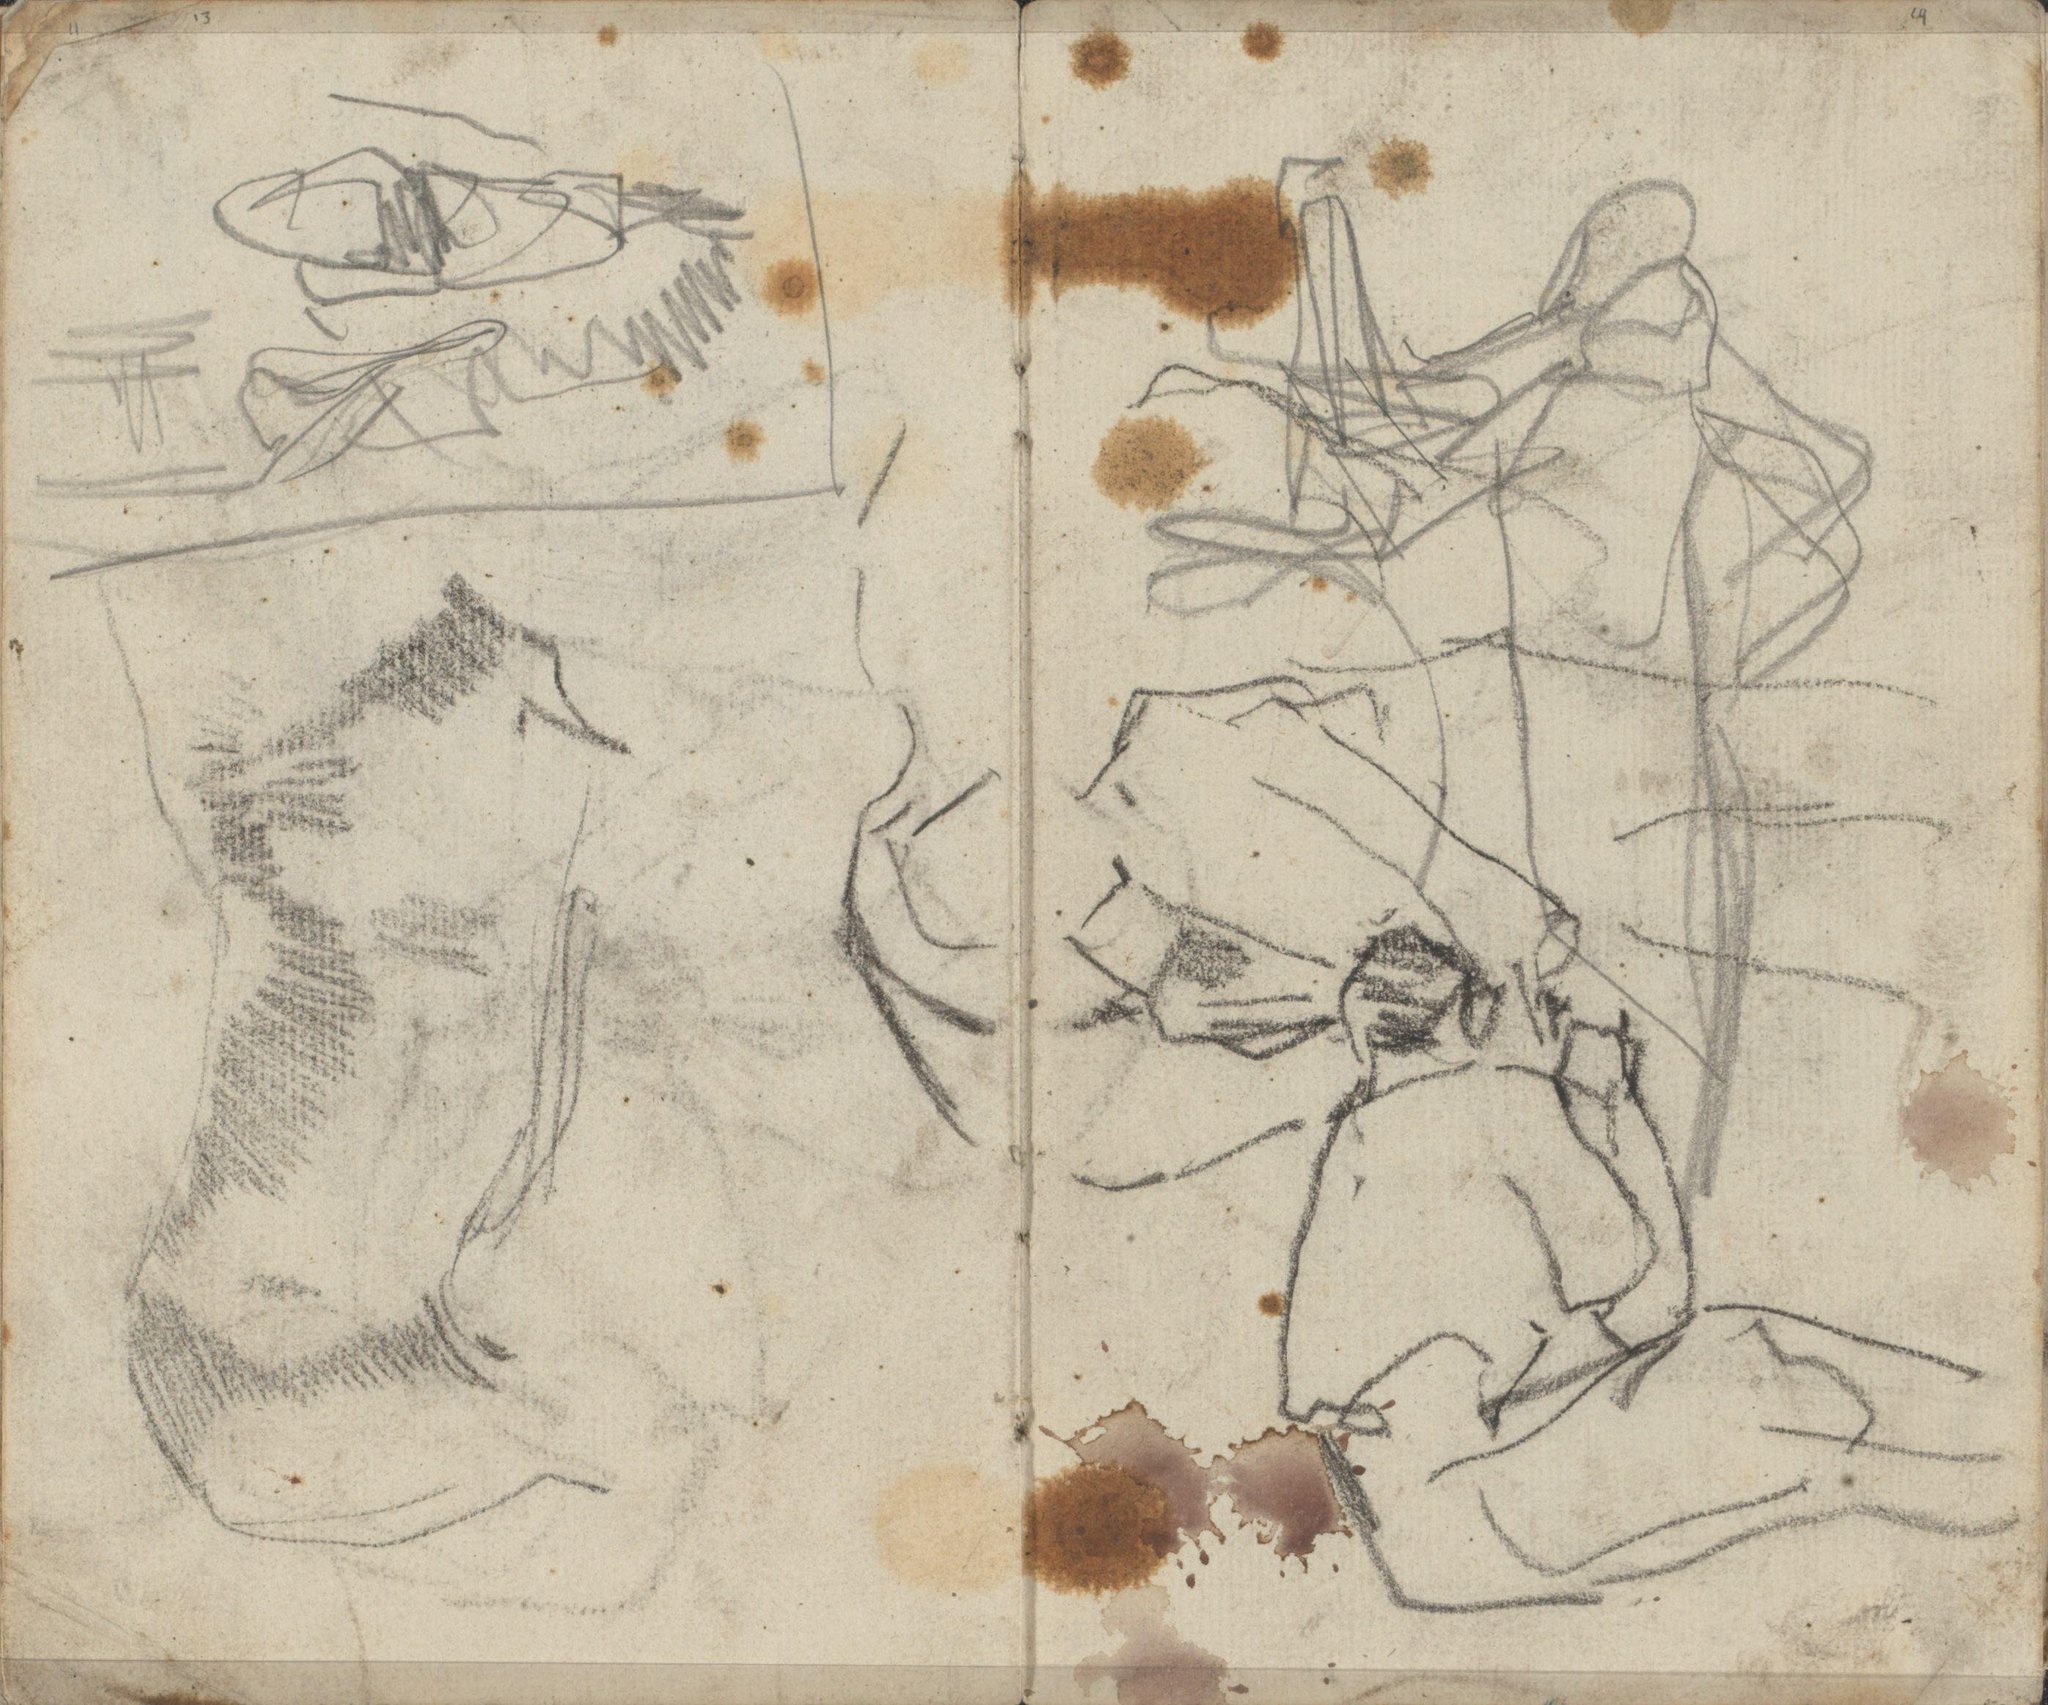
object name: sketchbook leaf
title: Studieblad met paarden en figuren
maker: george hendrik breitner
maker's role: draughtsman, painter, print maker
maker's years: 1857-1923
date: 1883-1885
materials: chalk, paper, pencil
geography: the hague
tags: adult woman, adult man, horse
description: Pagina 13 en pagina 14 uit een schetsboek met 17 bladen.